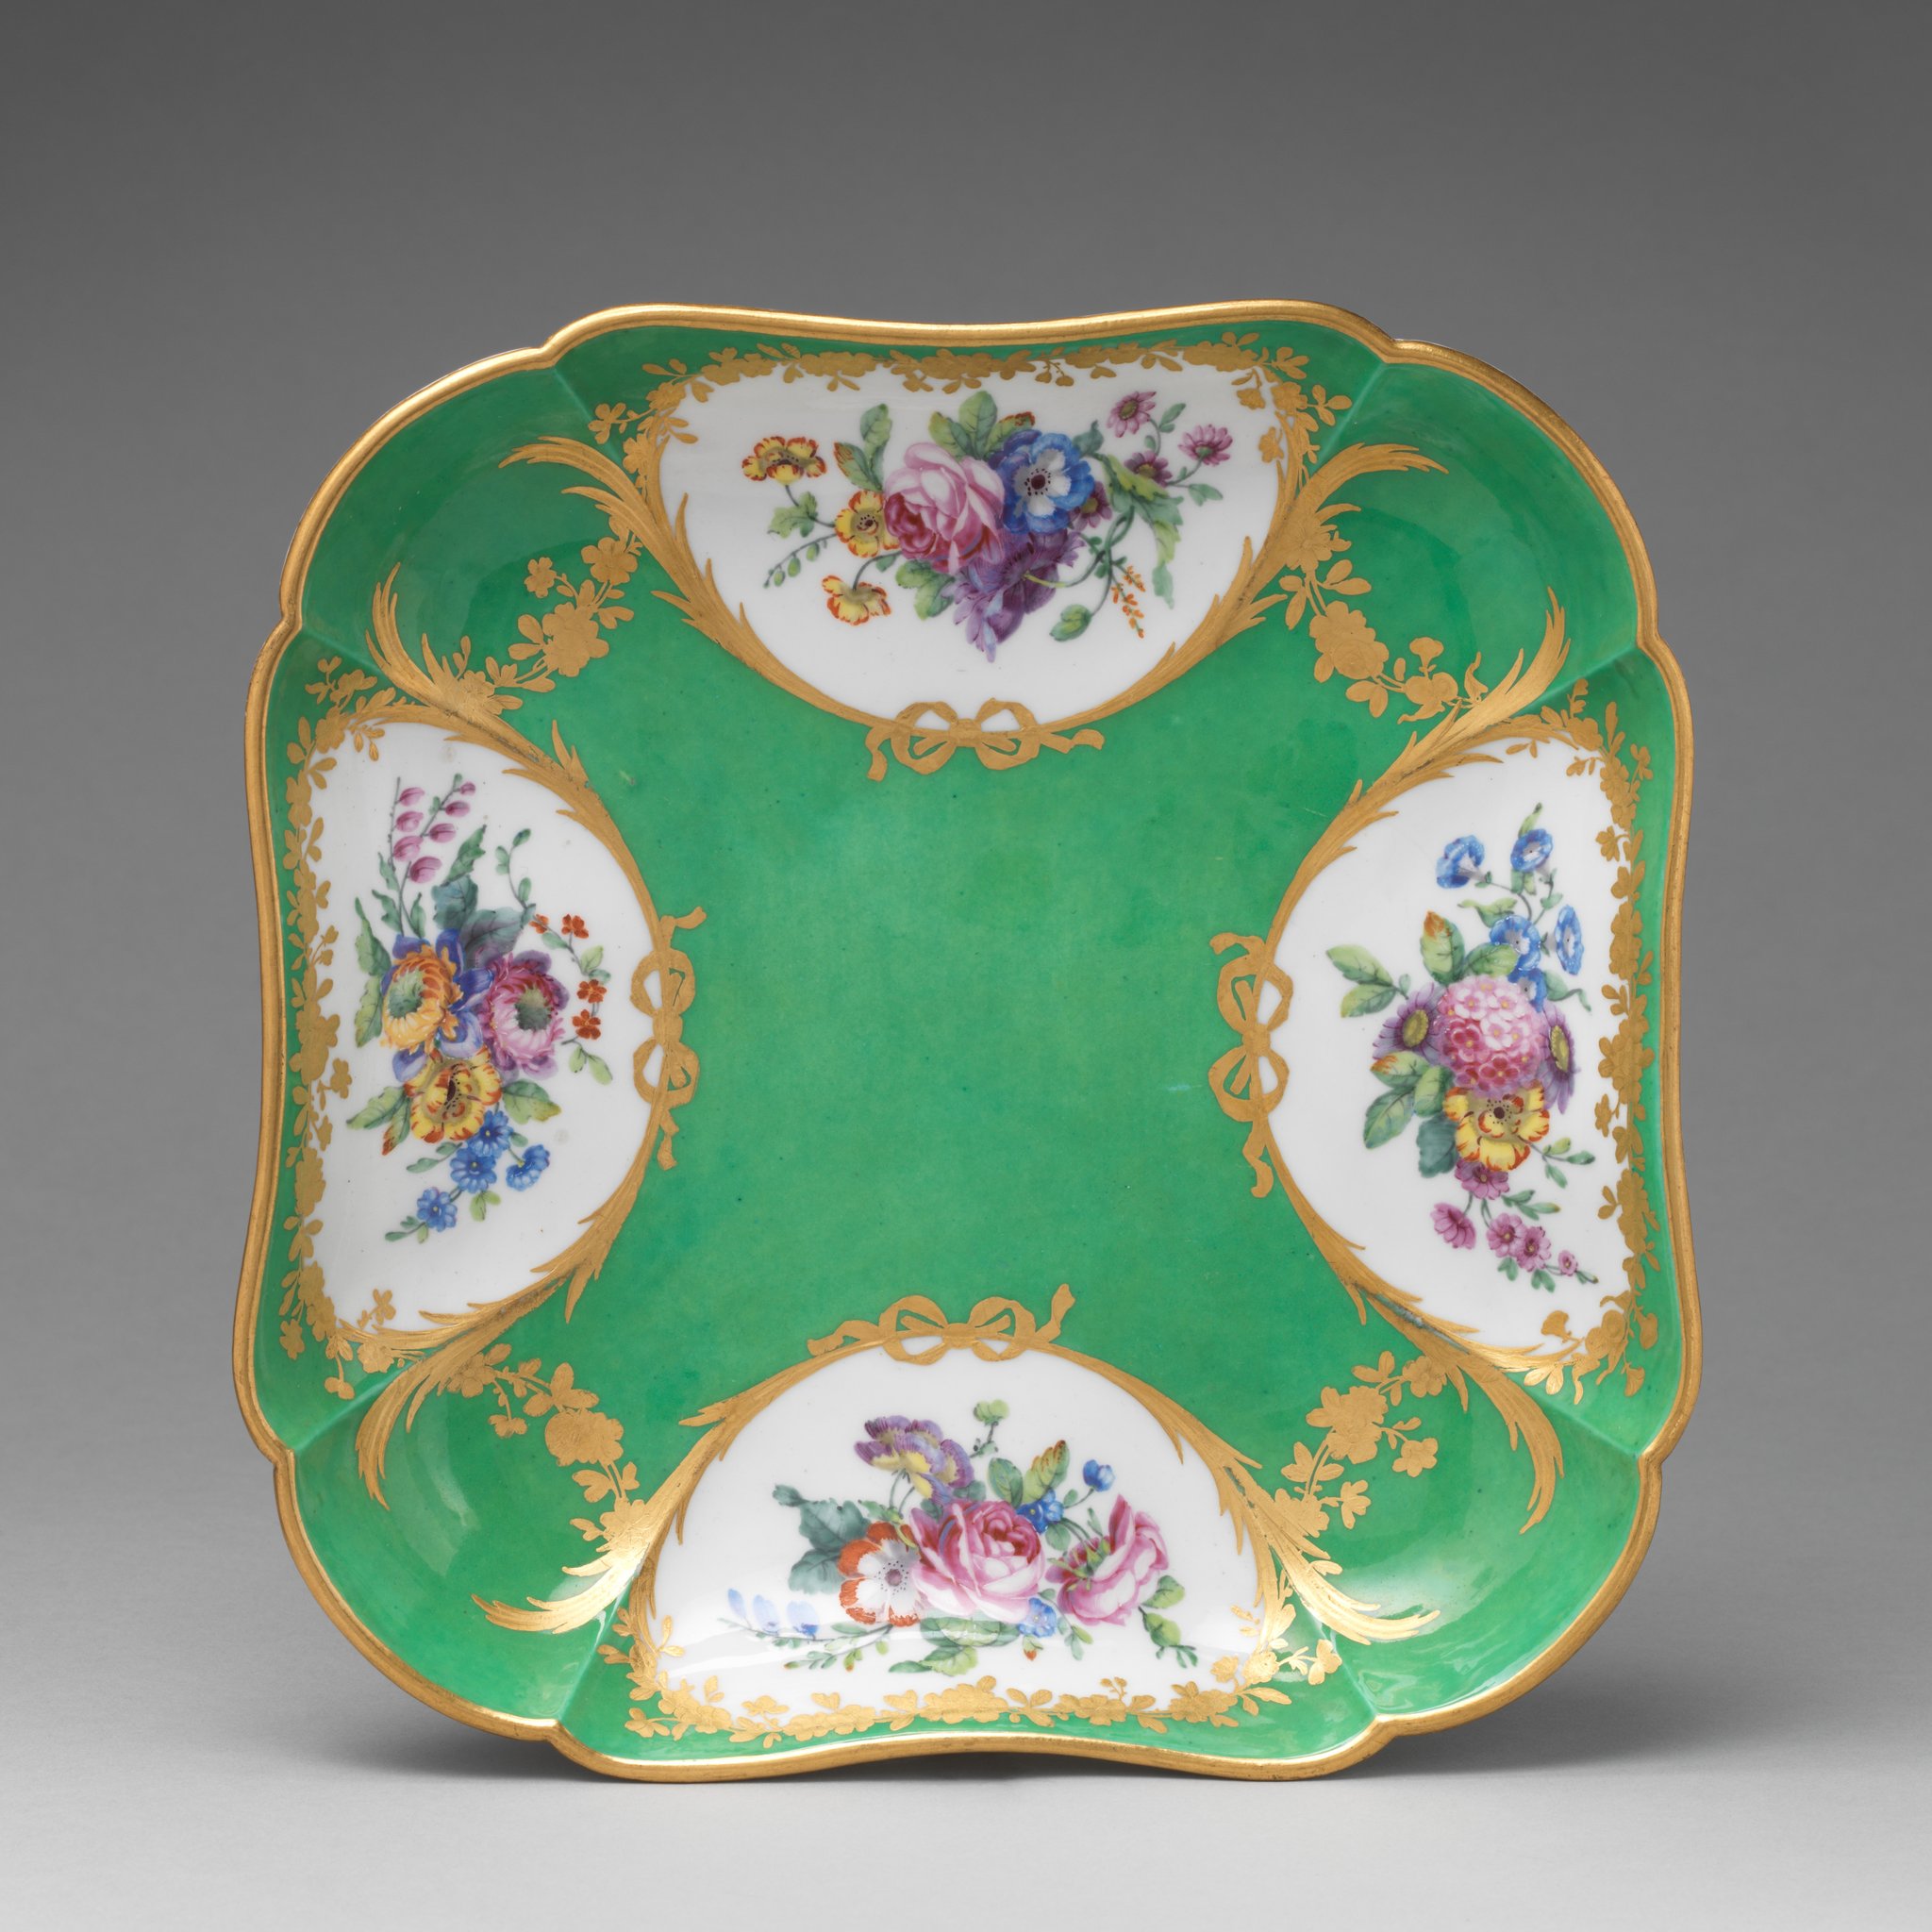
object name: fruit dish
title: Fruit dish (compotier carré) (one of six) (part of a service)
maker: sèvres manufactory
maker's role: manufactory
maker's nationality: french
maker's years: 1740-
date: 1780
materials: soft paste porcelain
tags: flowers